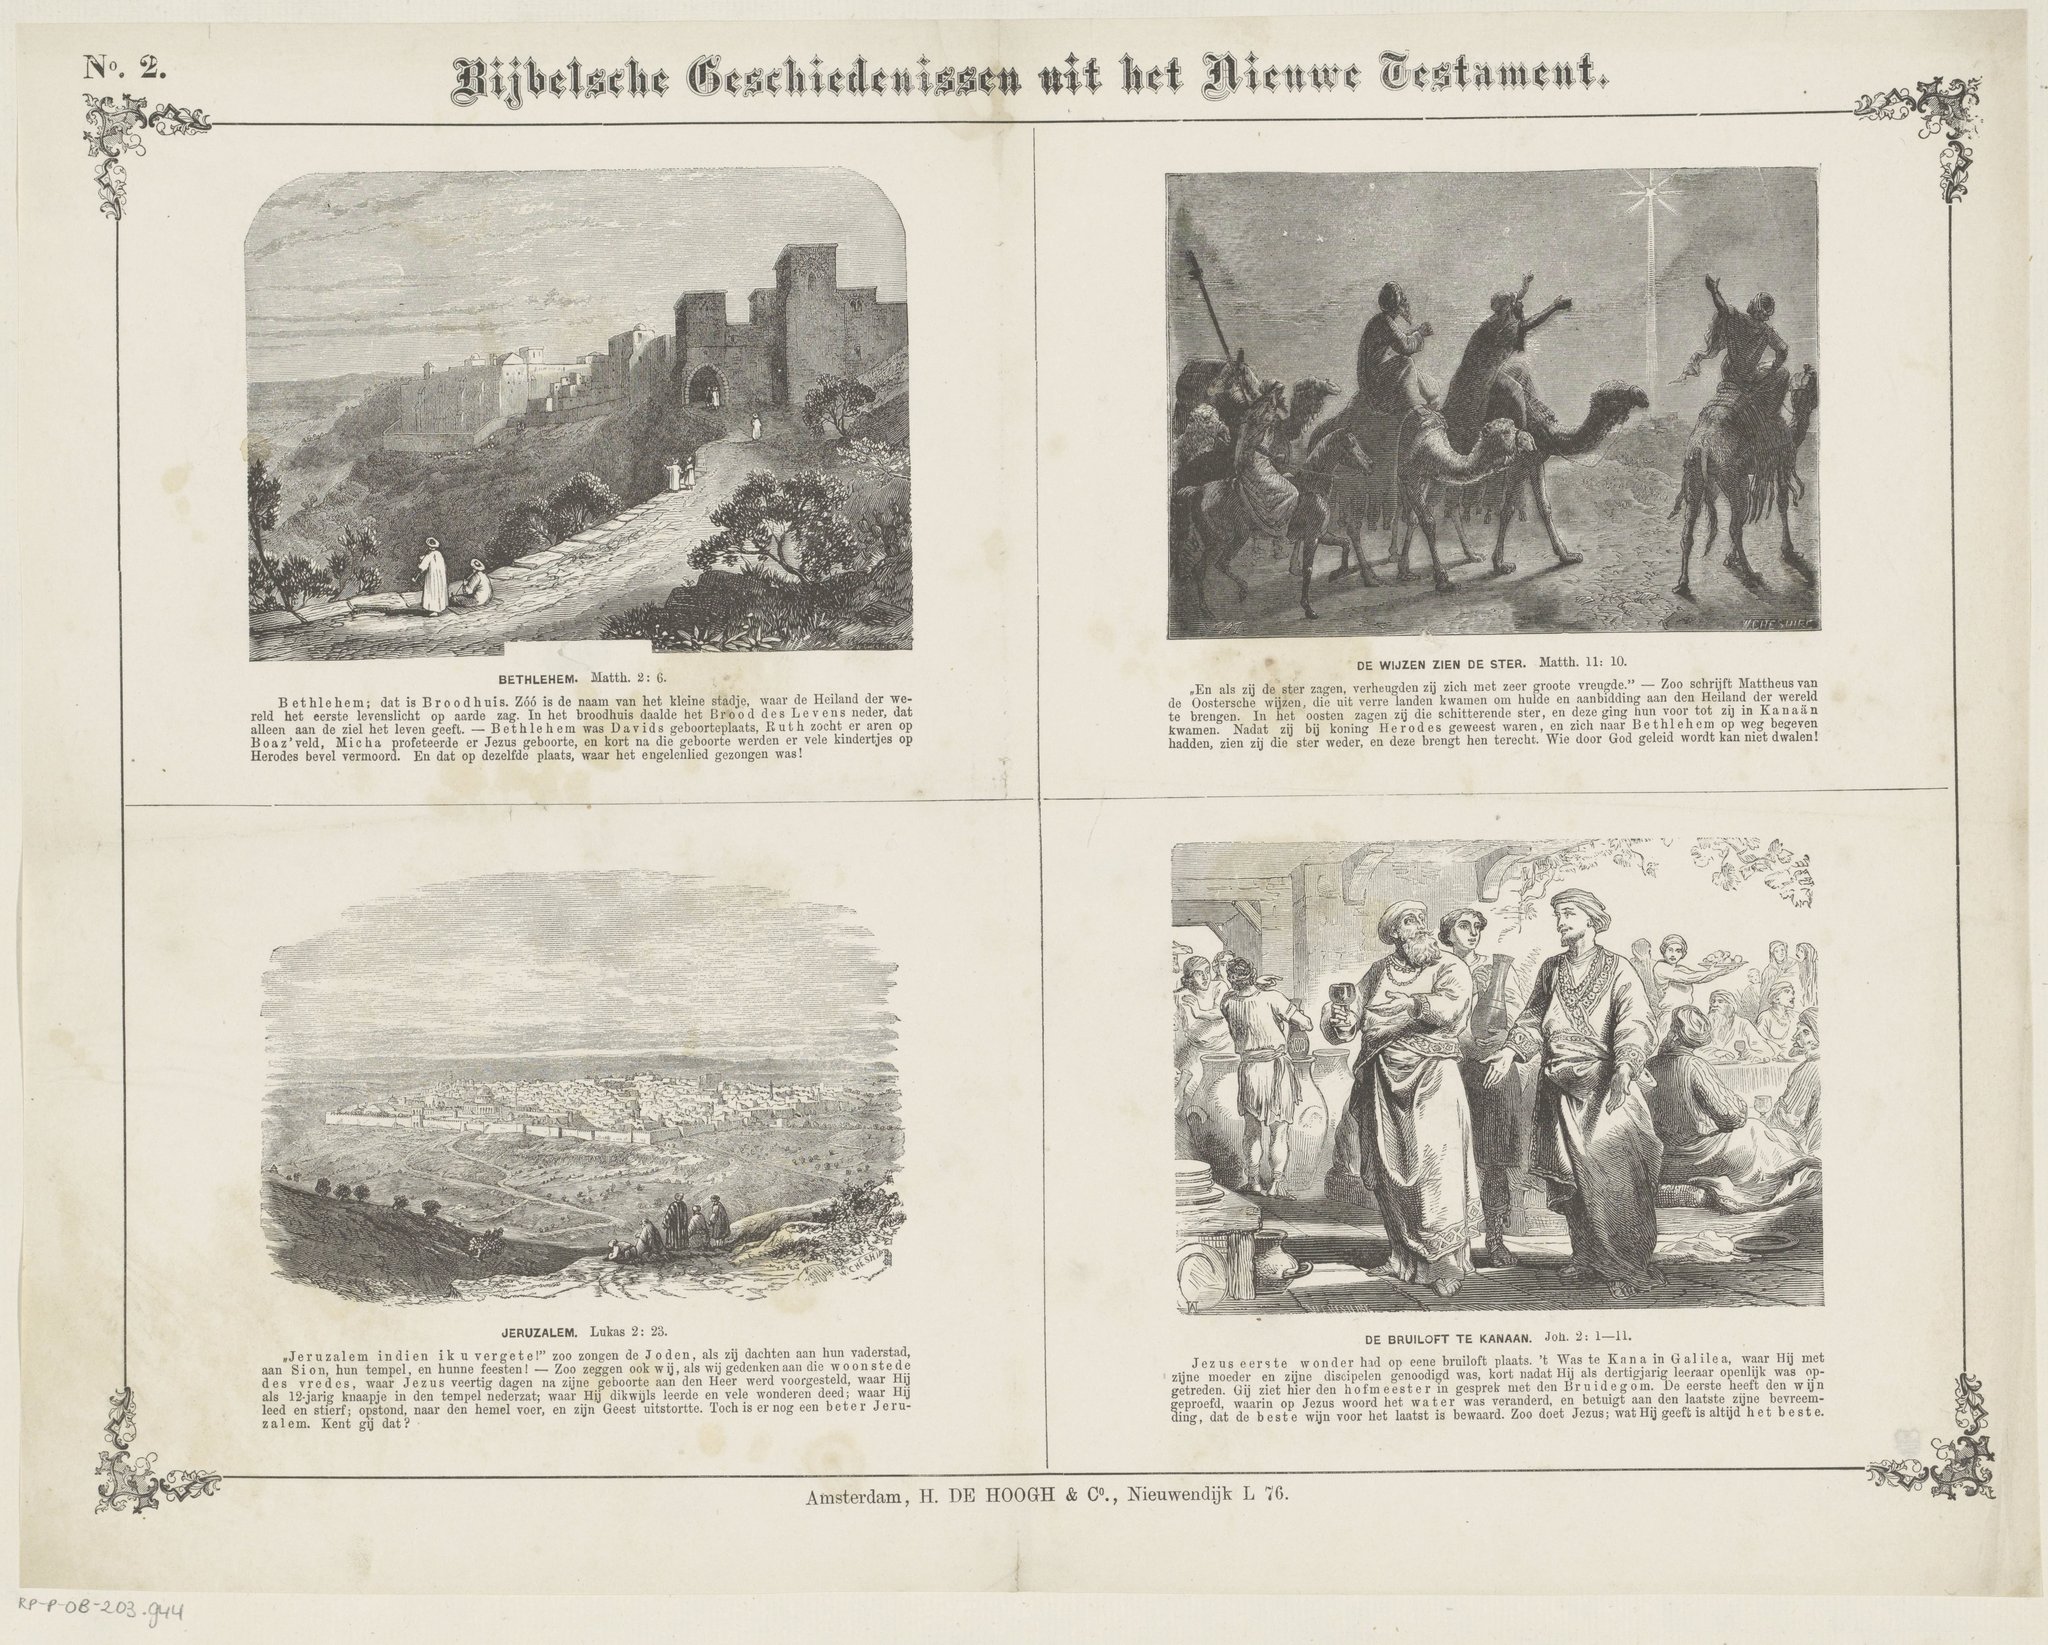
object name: print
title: Bijbelsche geschiedenissen uit het Nieuwe Testament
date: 1866-1871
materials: paper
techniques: letterpress printing, engraving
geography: amsterdam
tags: city-view, and landscape with man-made constructions, the story of the three wise men (kings or magi) (matthew 2:1-12), new testament, the marriage-feast at cana (john 2:1-11)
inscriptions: collector's mark: Lugt 2760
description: Blad met 4 voorstellingen van plaatsen en verhalen uit het Nieuwe Testament. Bethlehem, de drie wijzen zien een ster, Jeruzalem en de bruiloft te Kana. Onder elke afbeelding de bijbehorende Bijbeltekst. Genummerd linksboven: No. 2.